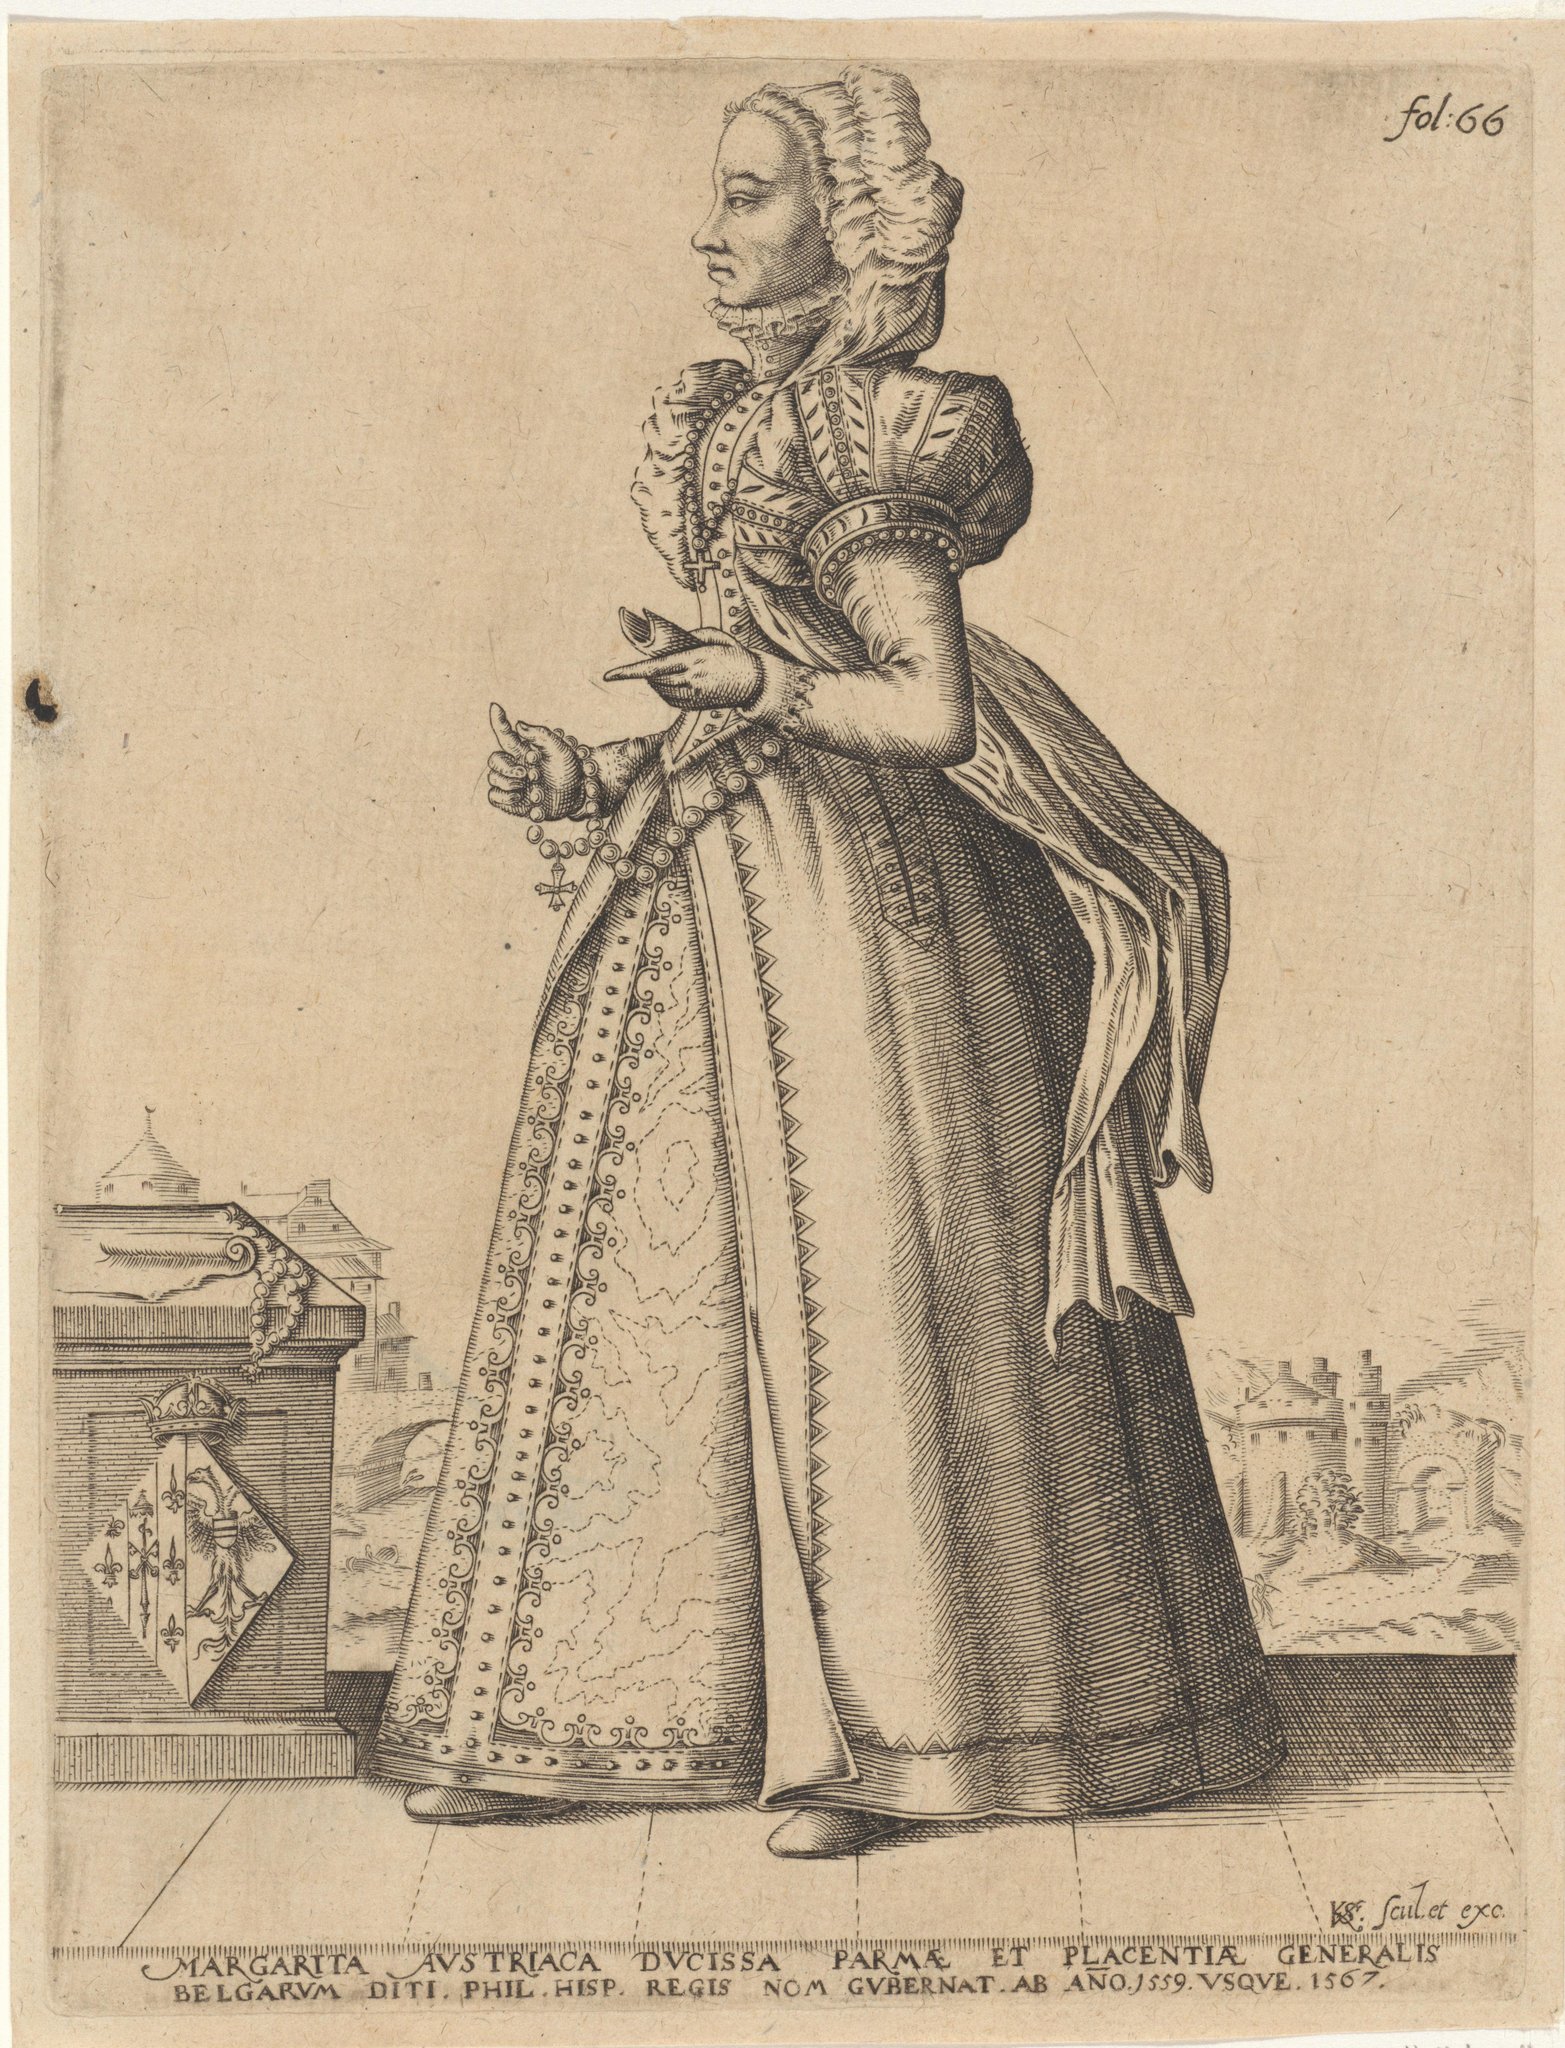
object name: print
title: Portret van Margaretha van Parma, landvoogdes der Nederlanden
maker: karel van sichem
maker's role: print maker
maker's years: 1575-1604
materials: paper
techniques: engraving, etching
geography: amsterdam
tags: oudenaarde, ortona, landvoogd, landvoogdes der nederlanden margaretha van parma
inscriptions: collector's mark: Lugt 2228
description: Portret van Margaretha van Parma, landvoogdes der Nederlanden. Zij houdt een stuk papier in de ene hand en een rozenkrans in de andere. Op een piëdestal naast haar liggen een tweede rozenkrans en nog een opgerold stuk papier, Tegen het voetstuk staat haar wapenschild. Op de achtergrond een landschap met een stad aan een rivier. Onder de prent staan haar naam, titels en functie. Rechtsboven de folio-aanduiding "fol. 66".